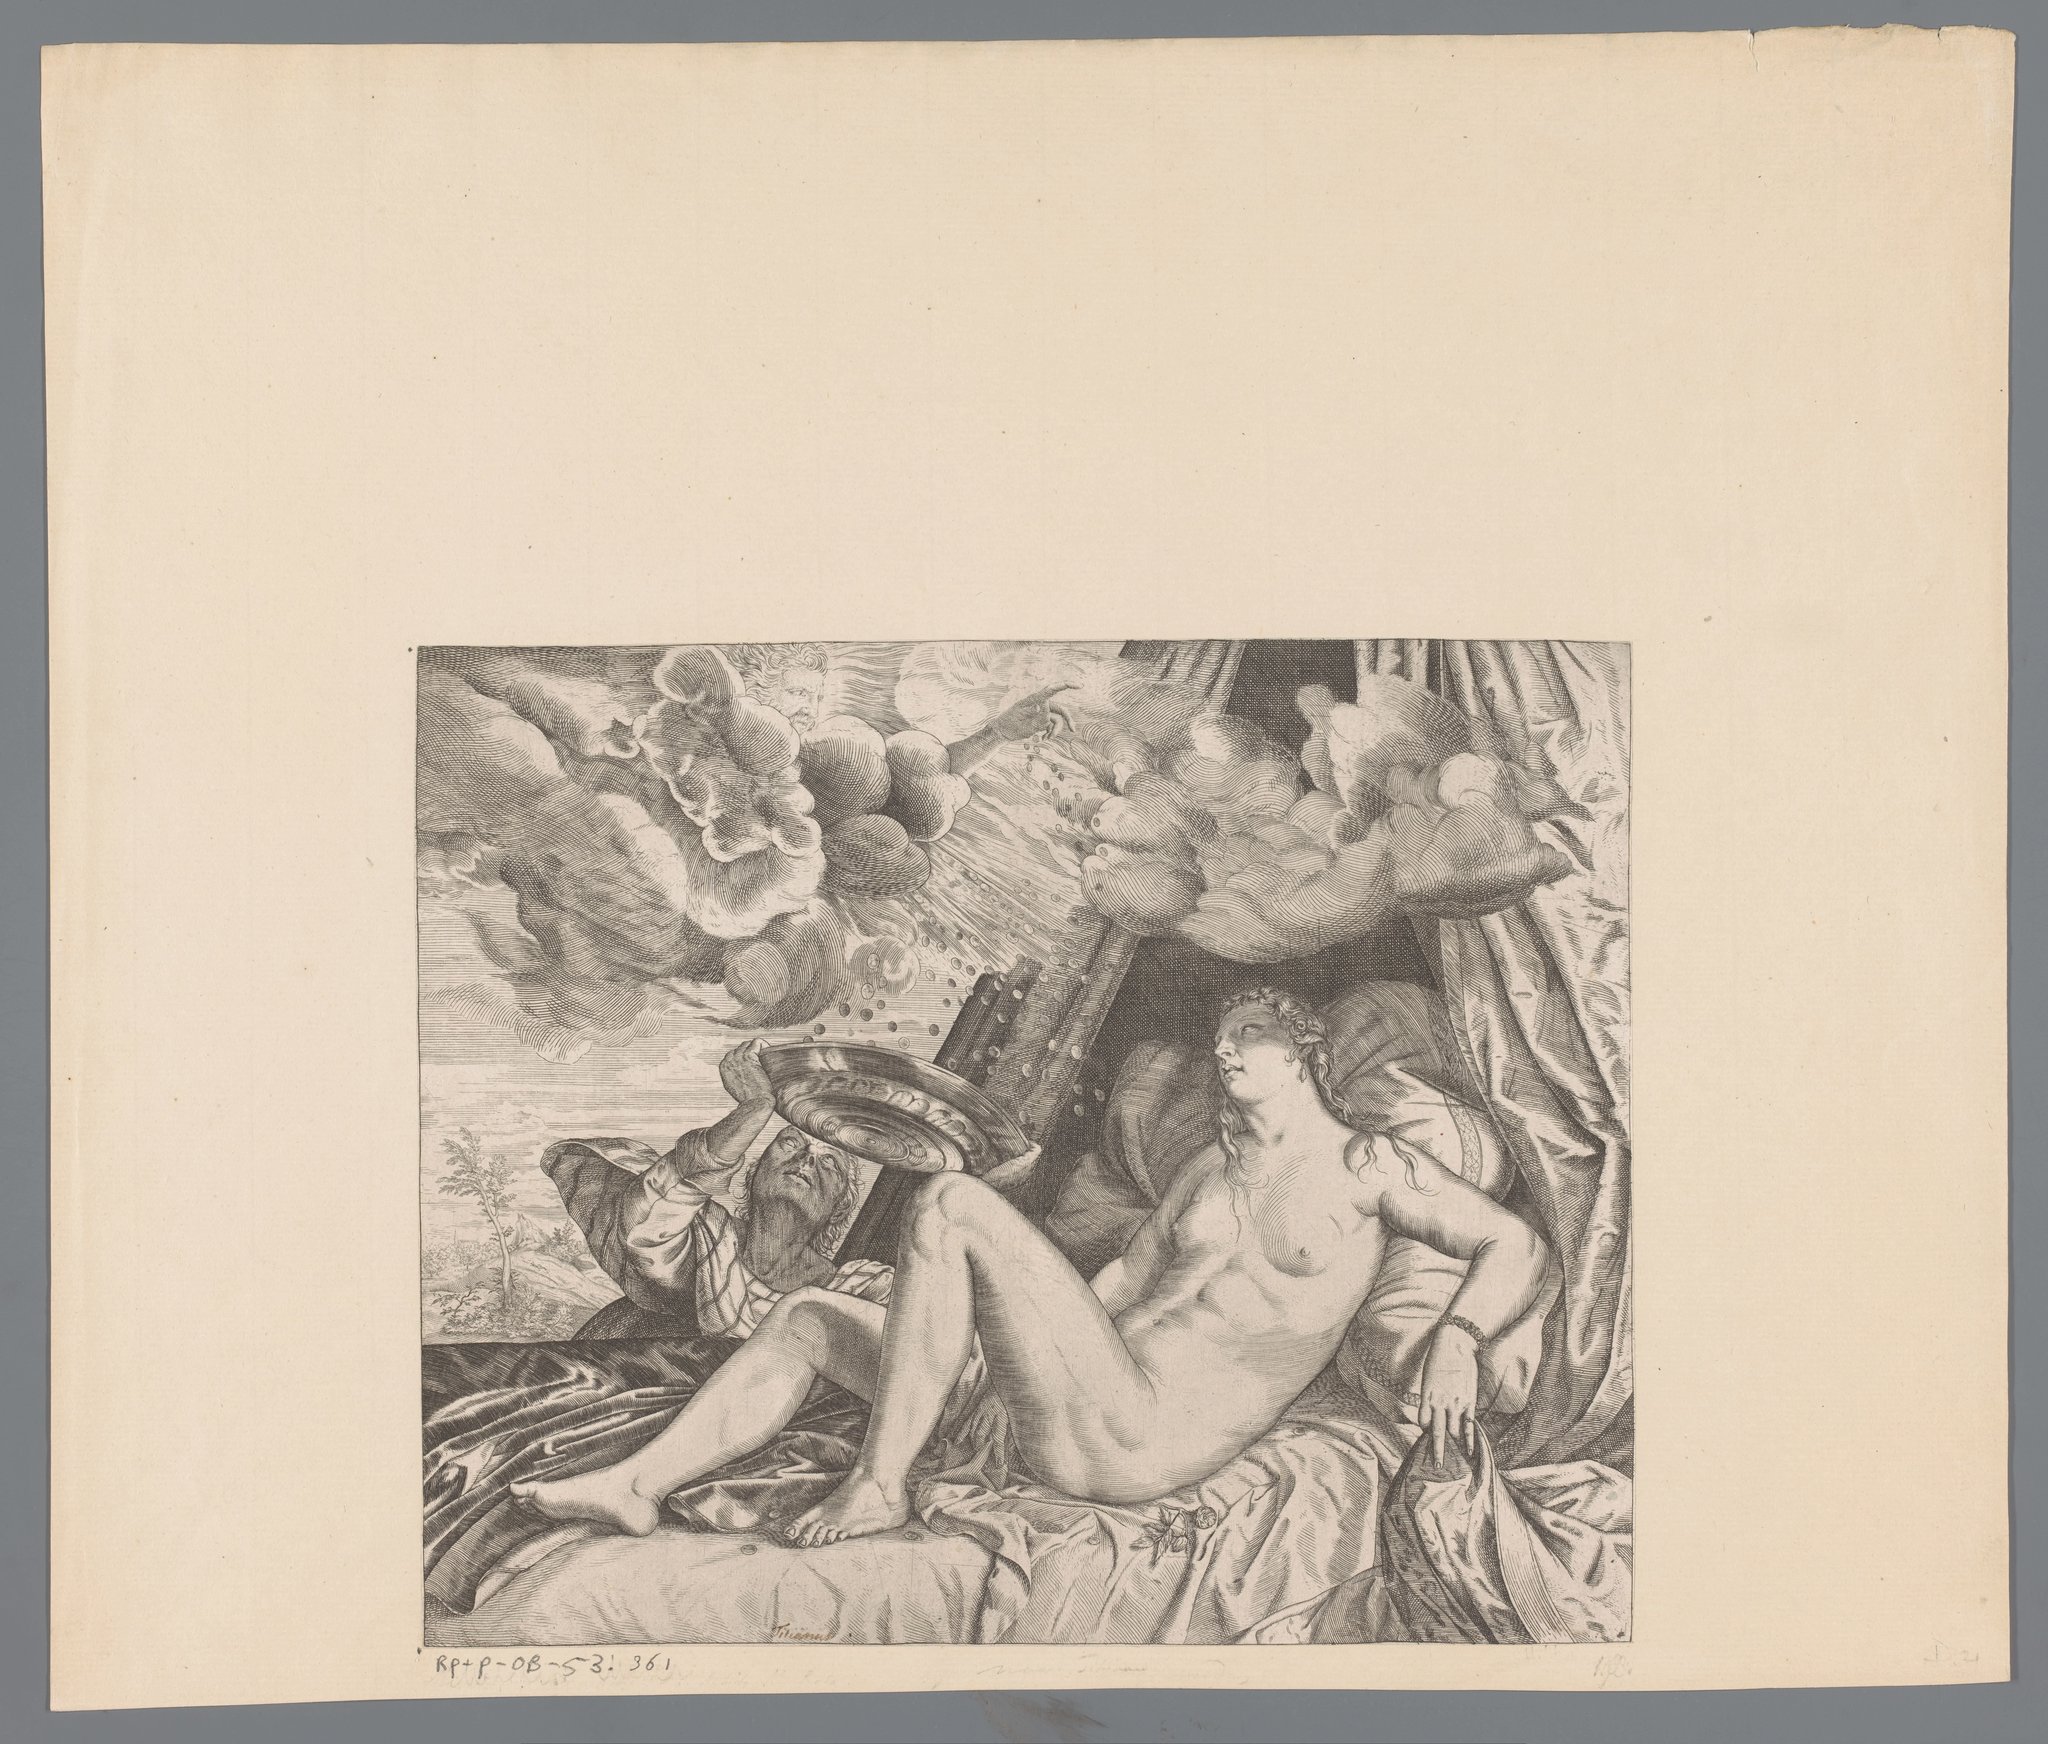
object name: print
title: Jupiter en Danaë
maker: melchior meier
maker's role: print maker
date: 1572-1582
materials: paper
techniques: engraving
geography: italy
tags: jupiter wooing danae; she is usually lying in bed receiving a shower of gold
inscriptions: inscription, collector's mark: Lugt 240, collector's mark: Lugt 1838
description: Jupiter daalt op Danaë neer in de vorm van een regen van gouden munten. Zijn hoofd is nog net zichtbaar tussen de wolken. Danaë ligt bloot op een bed terwijl haar dienares het goud opvangt met een schaal.